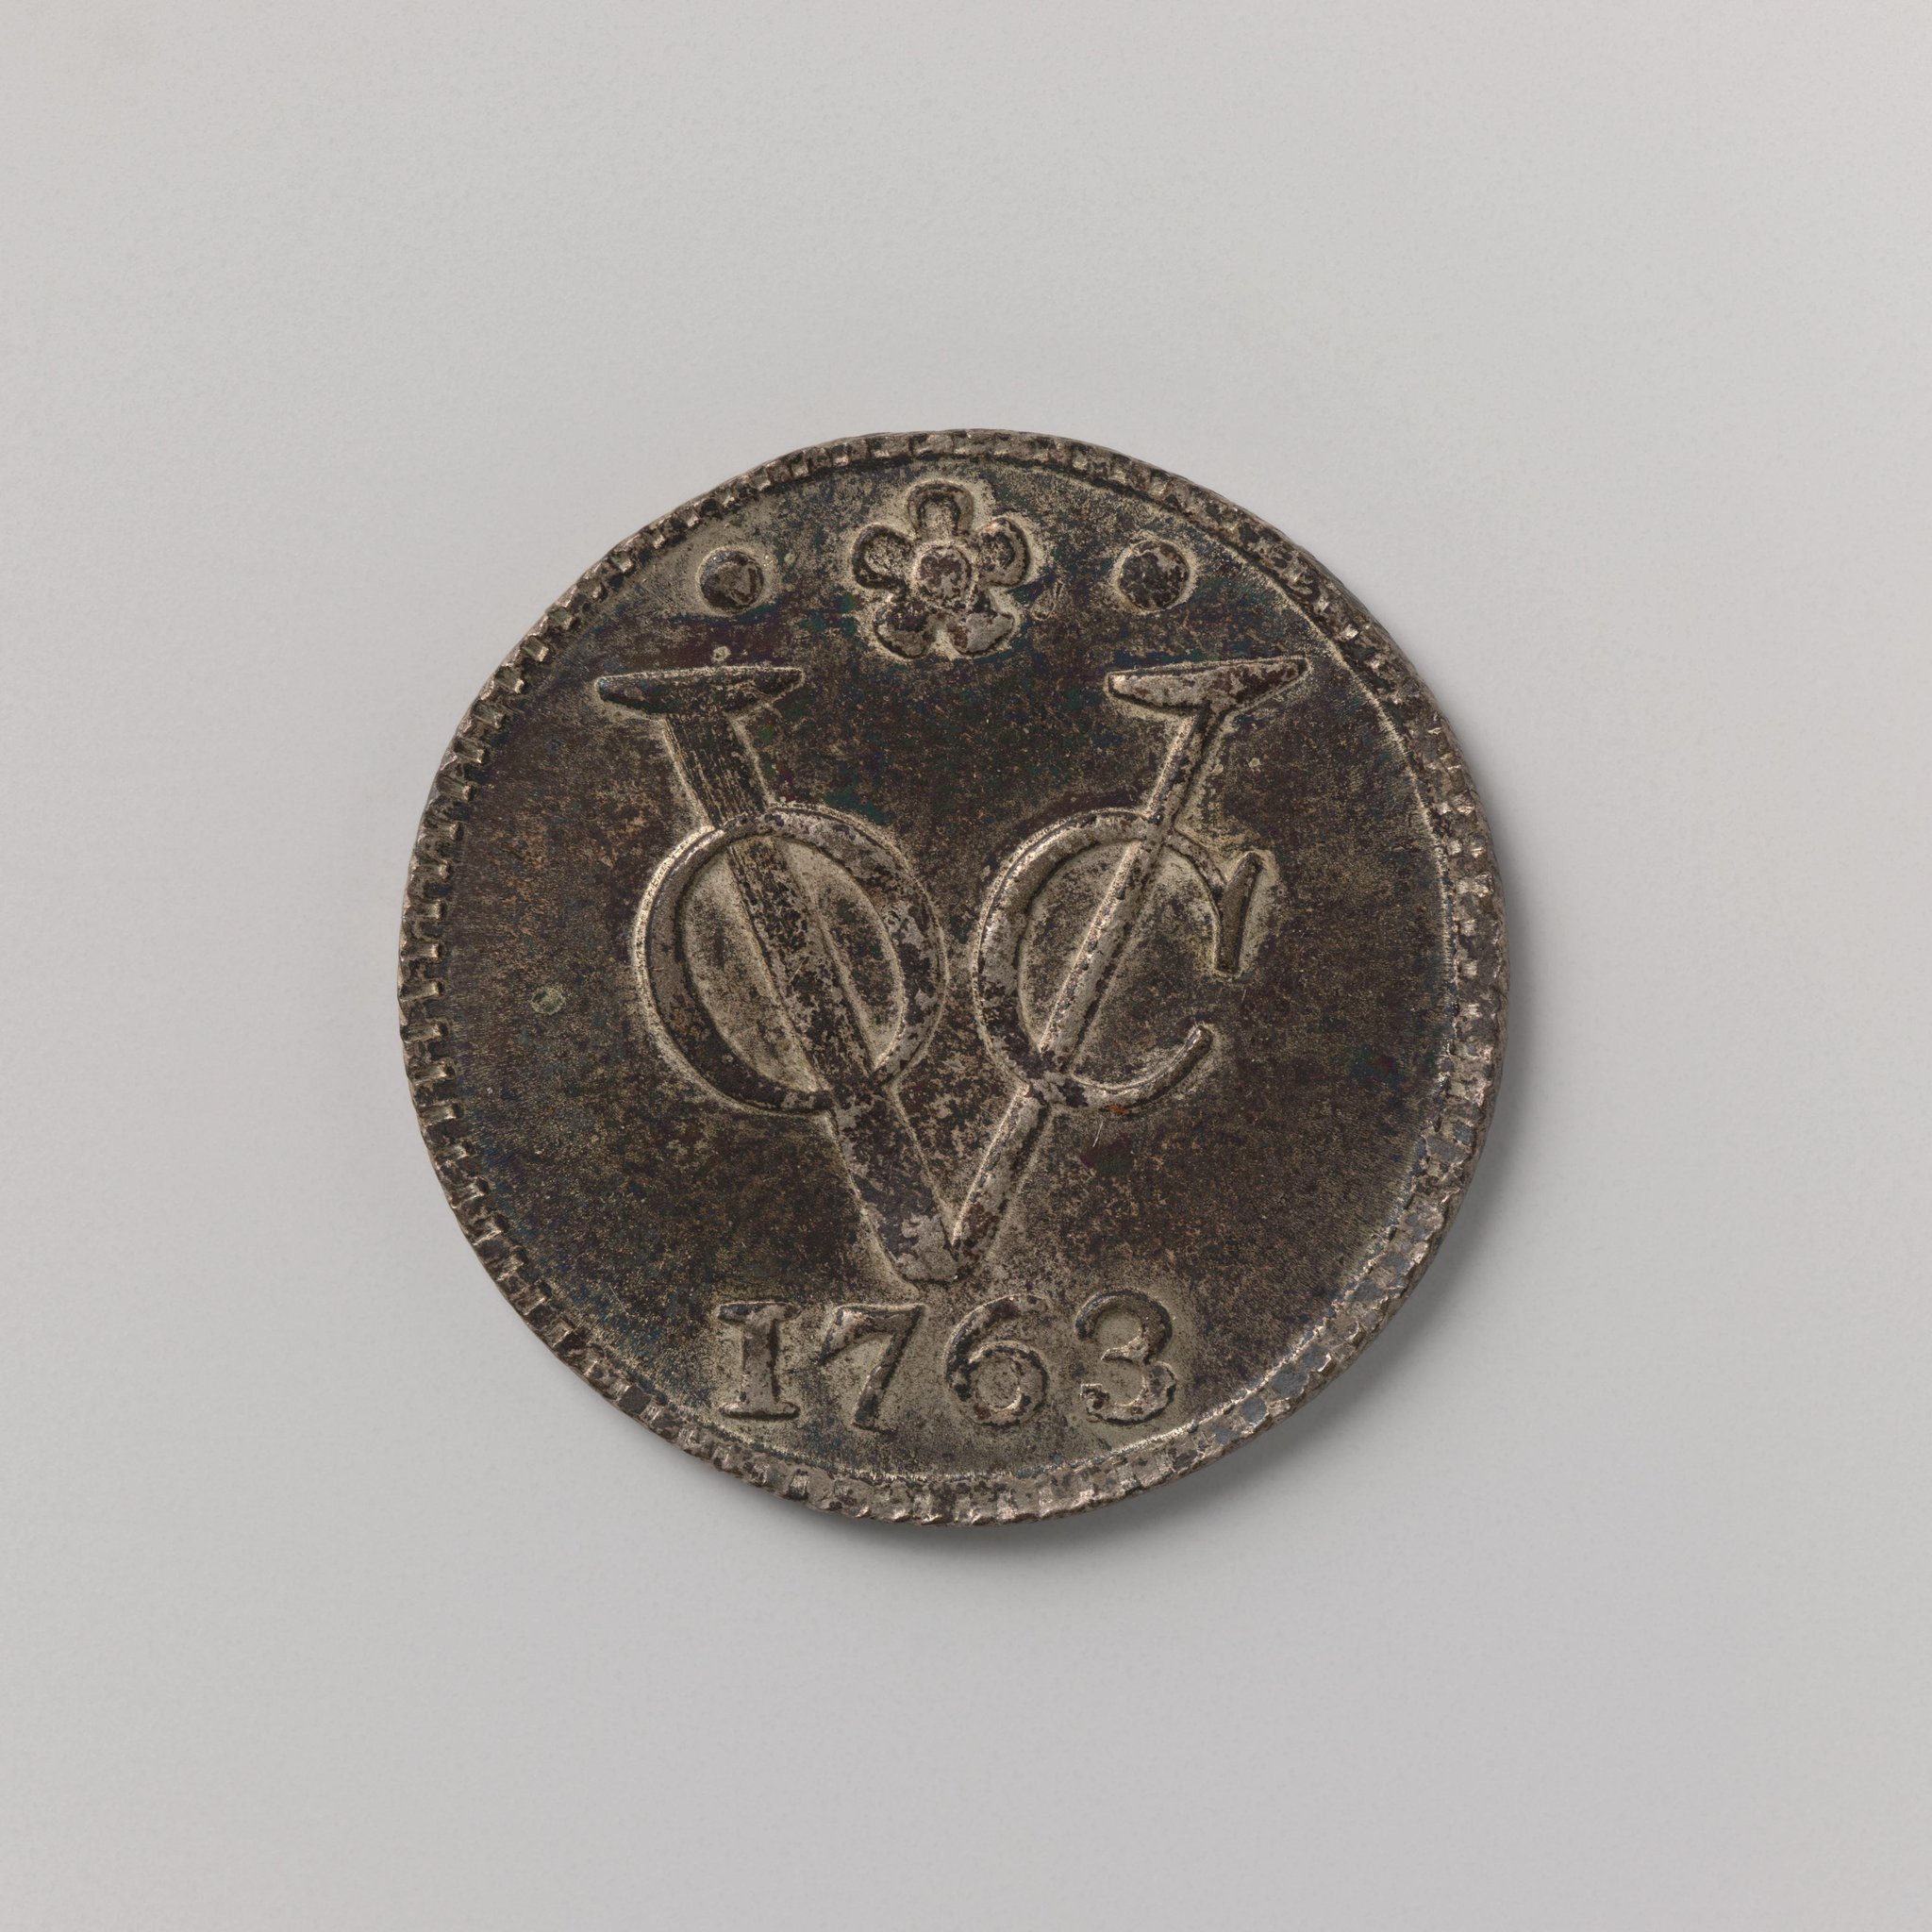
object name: coin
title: Afslag in zilver van een duit van de VOC uit Holland, 1763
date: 1763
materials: silver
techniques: striking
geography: dordrecht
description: Zilveren munt. Voorzijde: gekroond wapenschild van Holland. Keerzijde: monogram van de VOC, waarboven muntteken en waaronder jaartal. Kabelrand. Afslag in zilver.